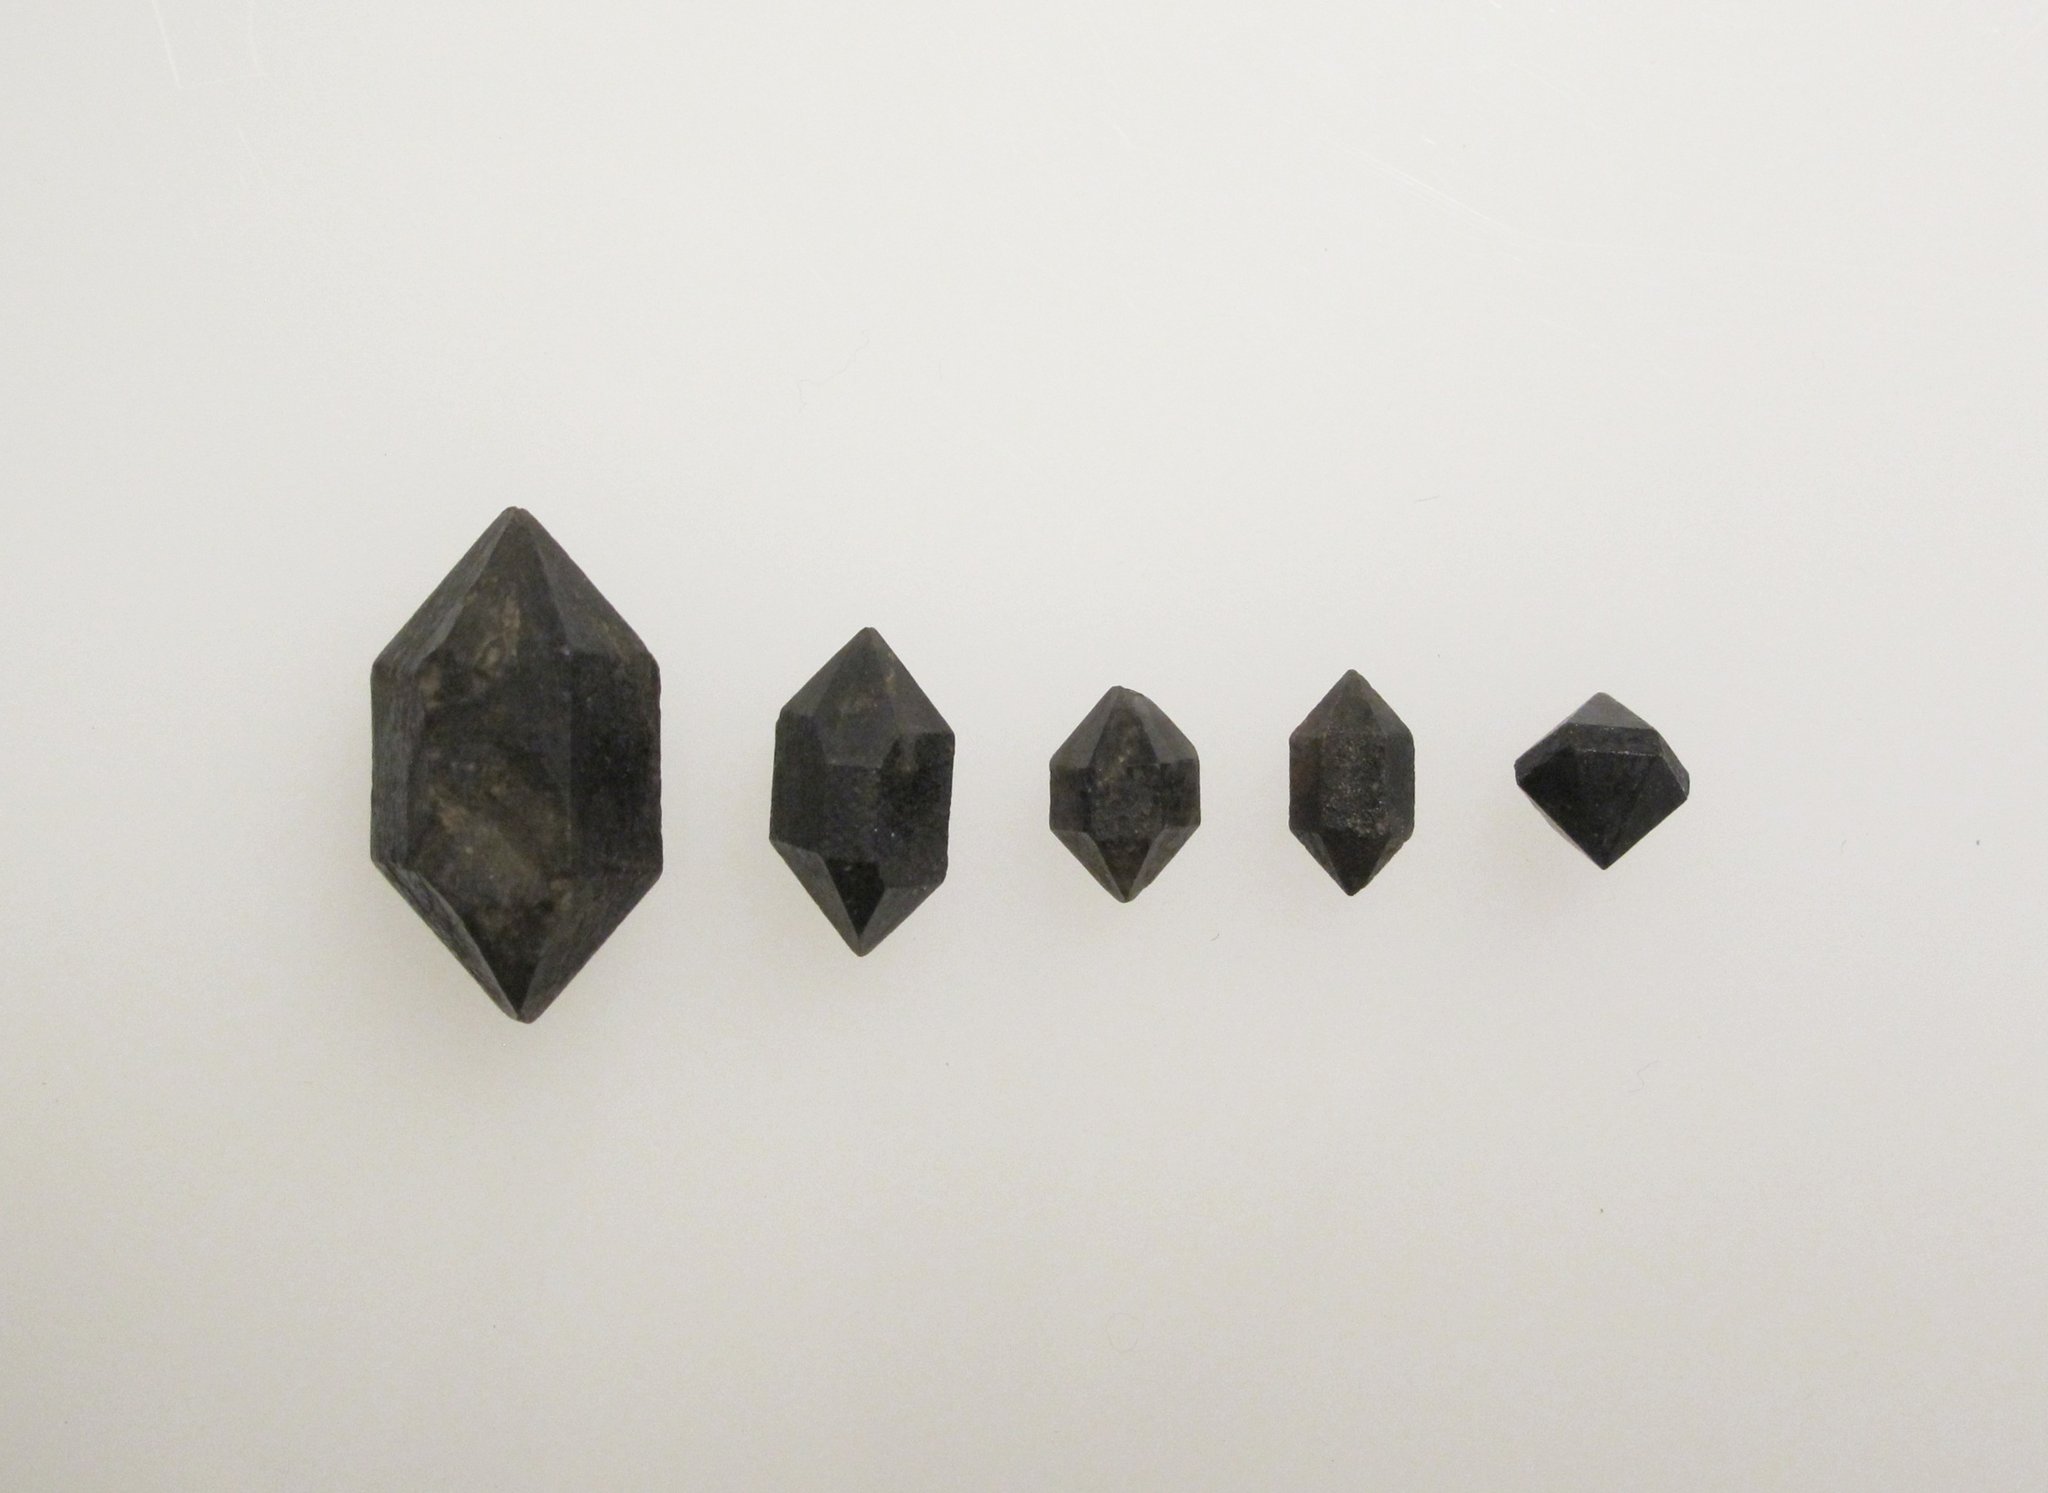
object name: crystal, quartz, 5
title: Crystals, quartz, 5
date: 7000 BCE-330 CE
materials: quartz